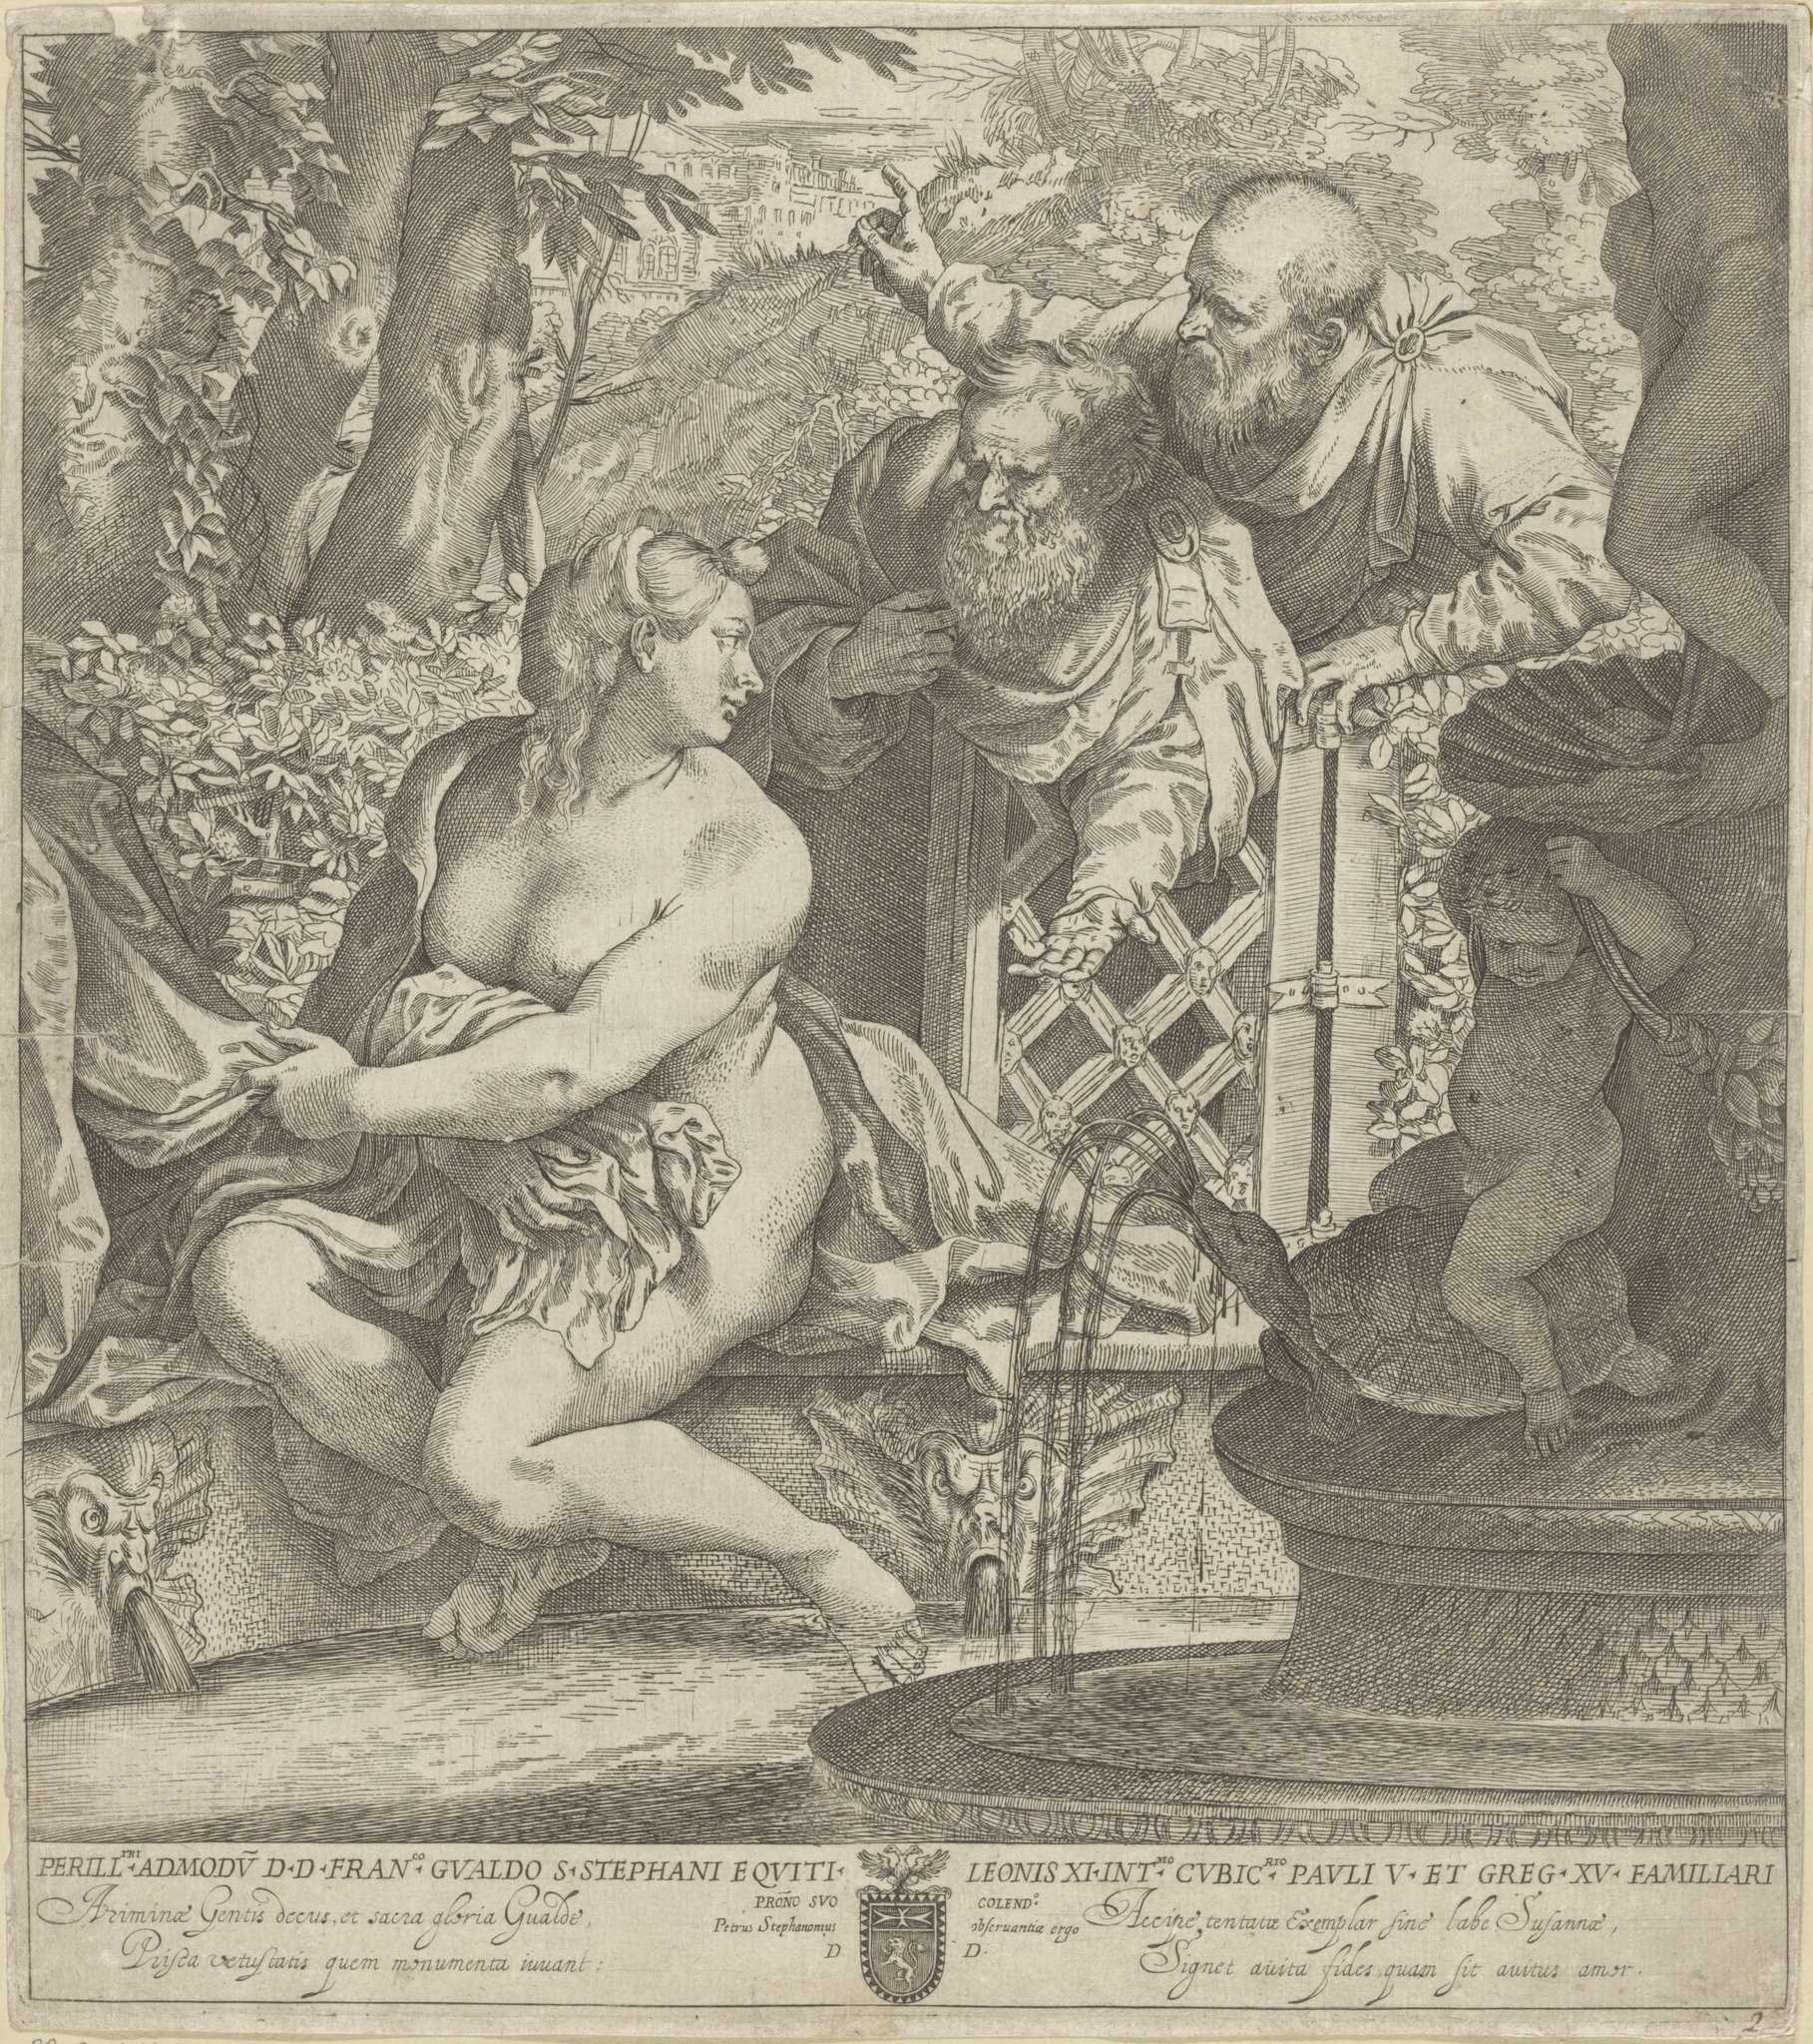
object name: print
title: Susanna en de ouderlingen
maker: annibale carracci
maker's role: draughtsman, print maker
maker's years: 1560-1609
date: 1590-1595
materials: paper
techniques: engraving, etching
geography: italy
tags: susanna bathing, usually in or near a fountain and sometimes accompanied by two female servants, garden fountain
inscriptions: collector's mark: Lugt 10, collector's mark: Lugt 11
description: De badende Susanna wordt lastiggevallen door twee oude mannen die dreigen haar aan te geven op beschuldiging van overspel indien zij zich tegen hen verzet. Op de voorgrond rechts een fontein met een putto op een schildpad en een naakste figuur staand op een schelp. Op de achtergrond een landschap. Tekst en wapenschild in ondermarge.